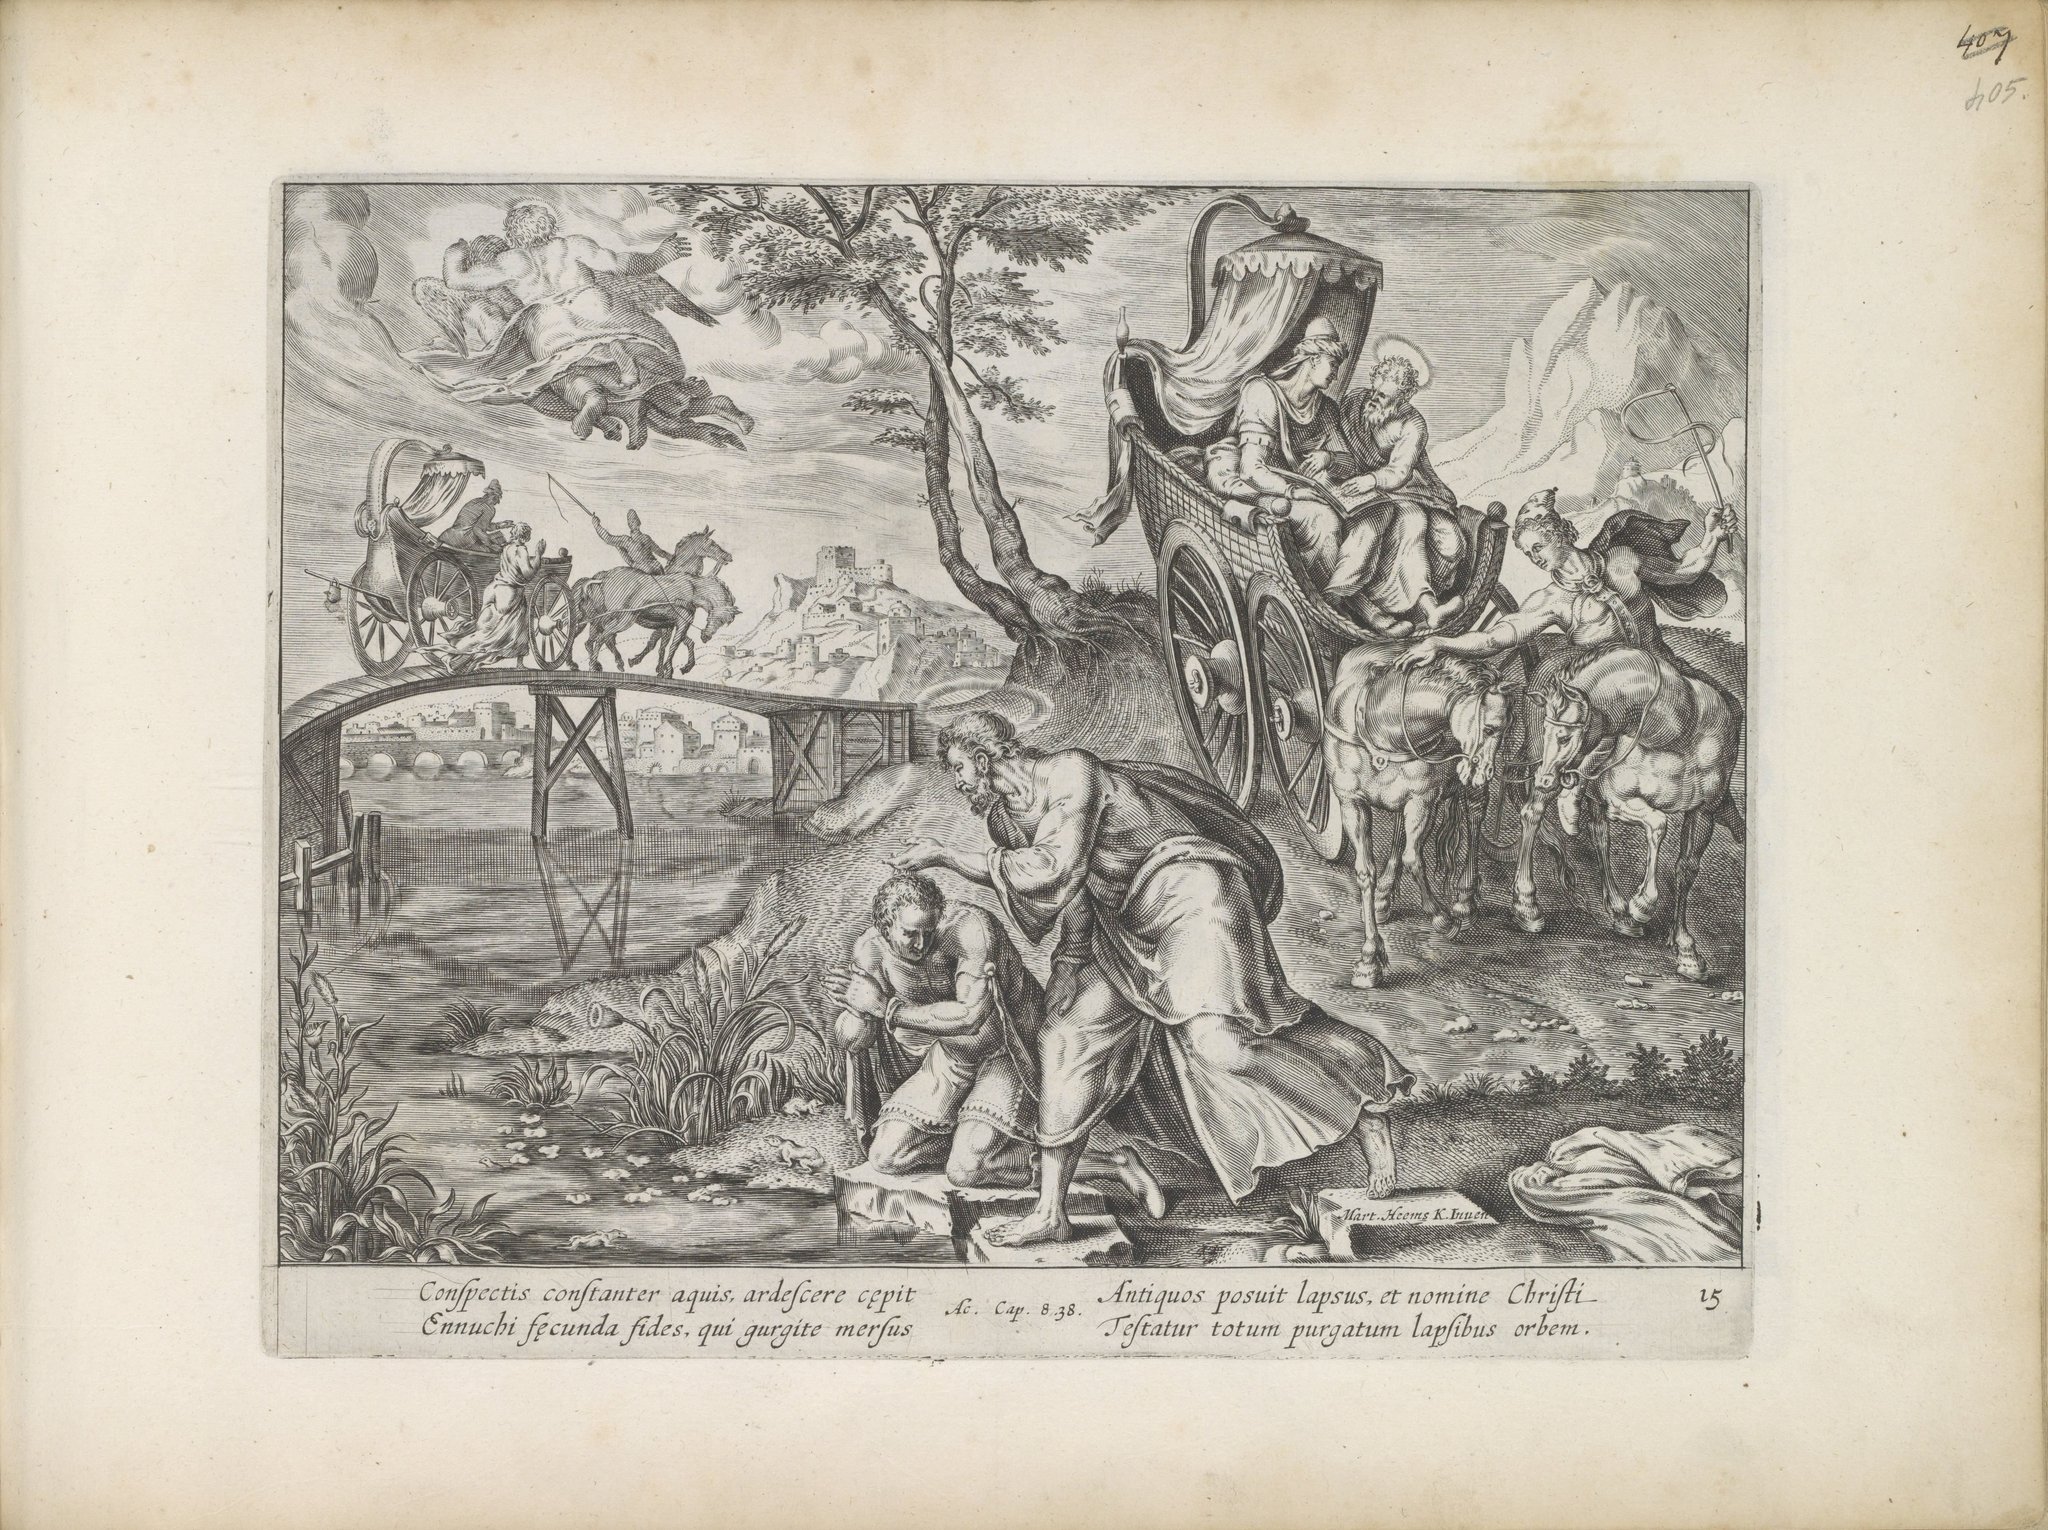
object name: print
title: Doop van de eunuch door Filippus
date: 1643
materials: paper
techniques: engraving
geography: amsterdam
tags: philip baptizes the eunuch, translocation of philip (by an angel), philip explains the scripture to the eunuch, philip meets the eunuch, who is travelling in a chariot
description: Filippus spreekt met de eunuch die hij ontmoet op de weg van Jeruzalem en Gaza. Als schatbewaarder van de koningin van Ethiopië rijdt de eunuch in een mooie koets. Filippus reist met de eunuch op om hem een tekst van de profeet Jesaja uit te leggen en vertelt hem over Christus. Als de eunuch gedoopt wil worden, doopt Filippus hem in een rivier. Vervolgens wordt hij door een engel meegenomen. Onder de voorstelling een verwijzing in het Latijn naar de Bijbeltekst in Hand. 8:38. Deze prent maakt deel uit van een album.